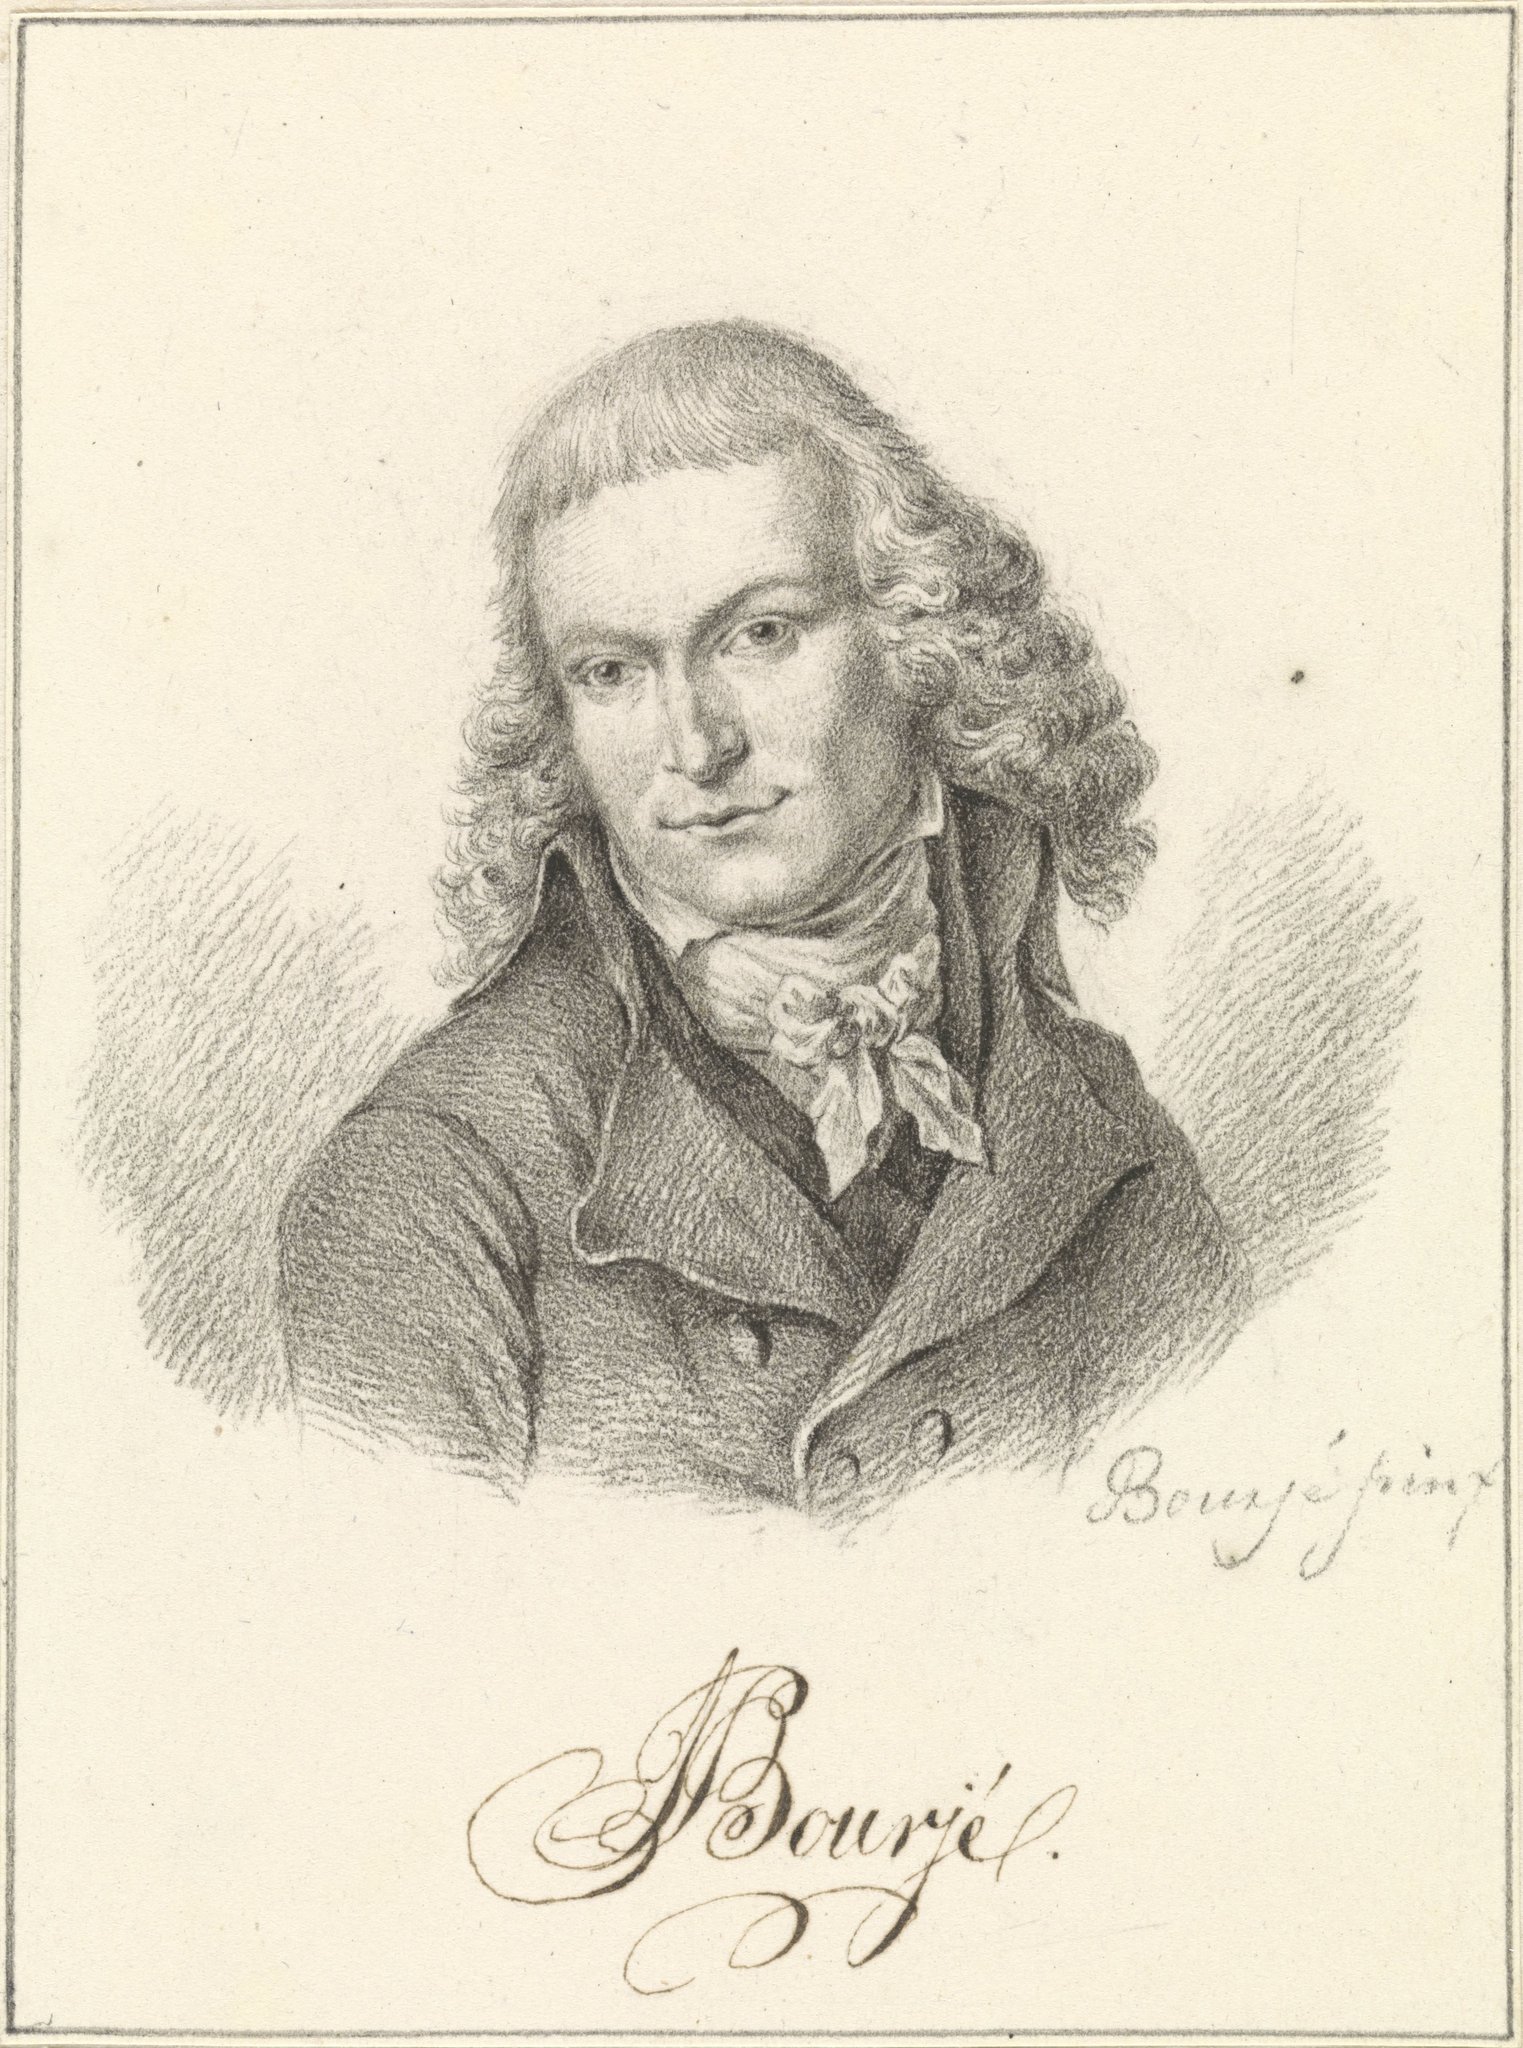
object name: drawing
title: Portret van Johan Pieter Bourjé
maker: pieter gaal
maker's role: draughtsman, print maker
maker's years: 1769-1819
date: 1800-1819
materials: chalk, paper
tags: johan pieter bourjé, historical persons, portrait, self-portrait of painter, portrait, self-portrait of artist, portrait, self-portrait of draughtsman